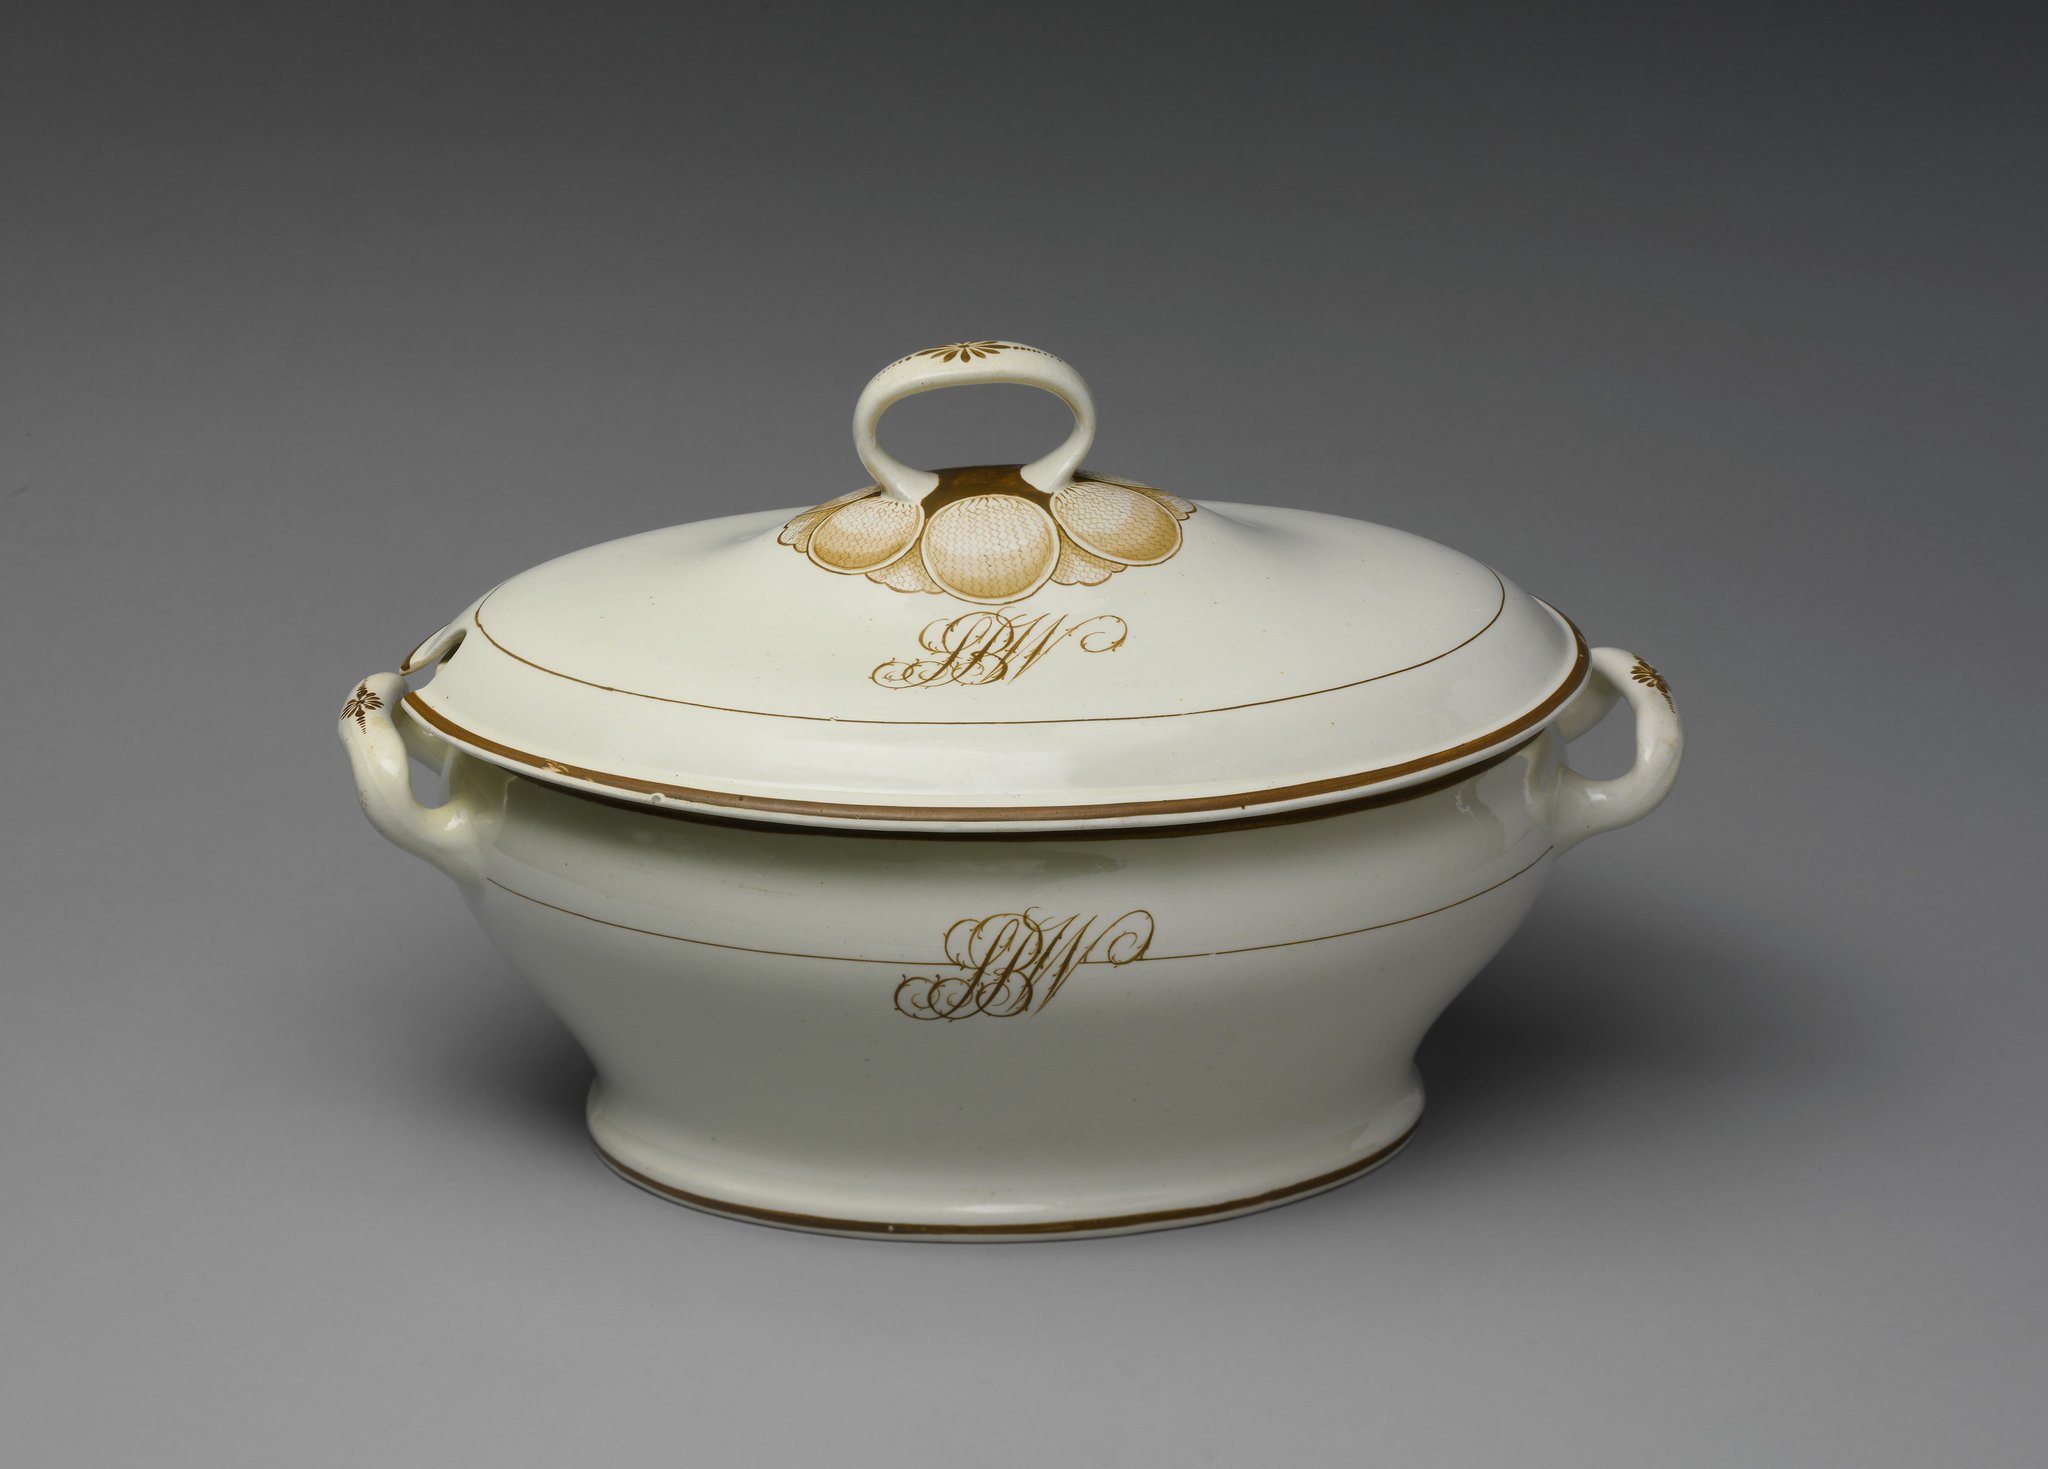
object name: tureen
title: Covered Tureen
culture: british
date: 1750-1775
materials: earthenware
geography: england